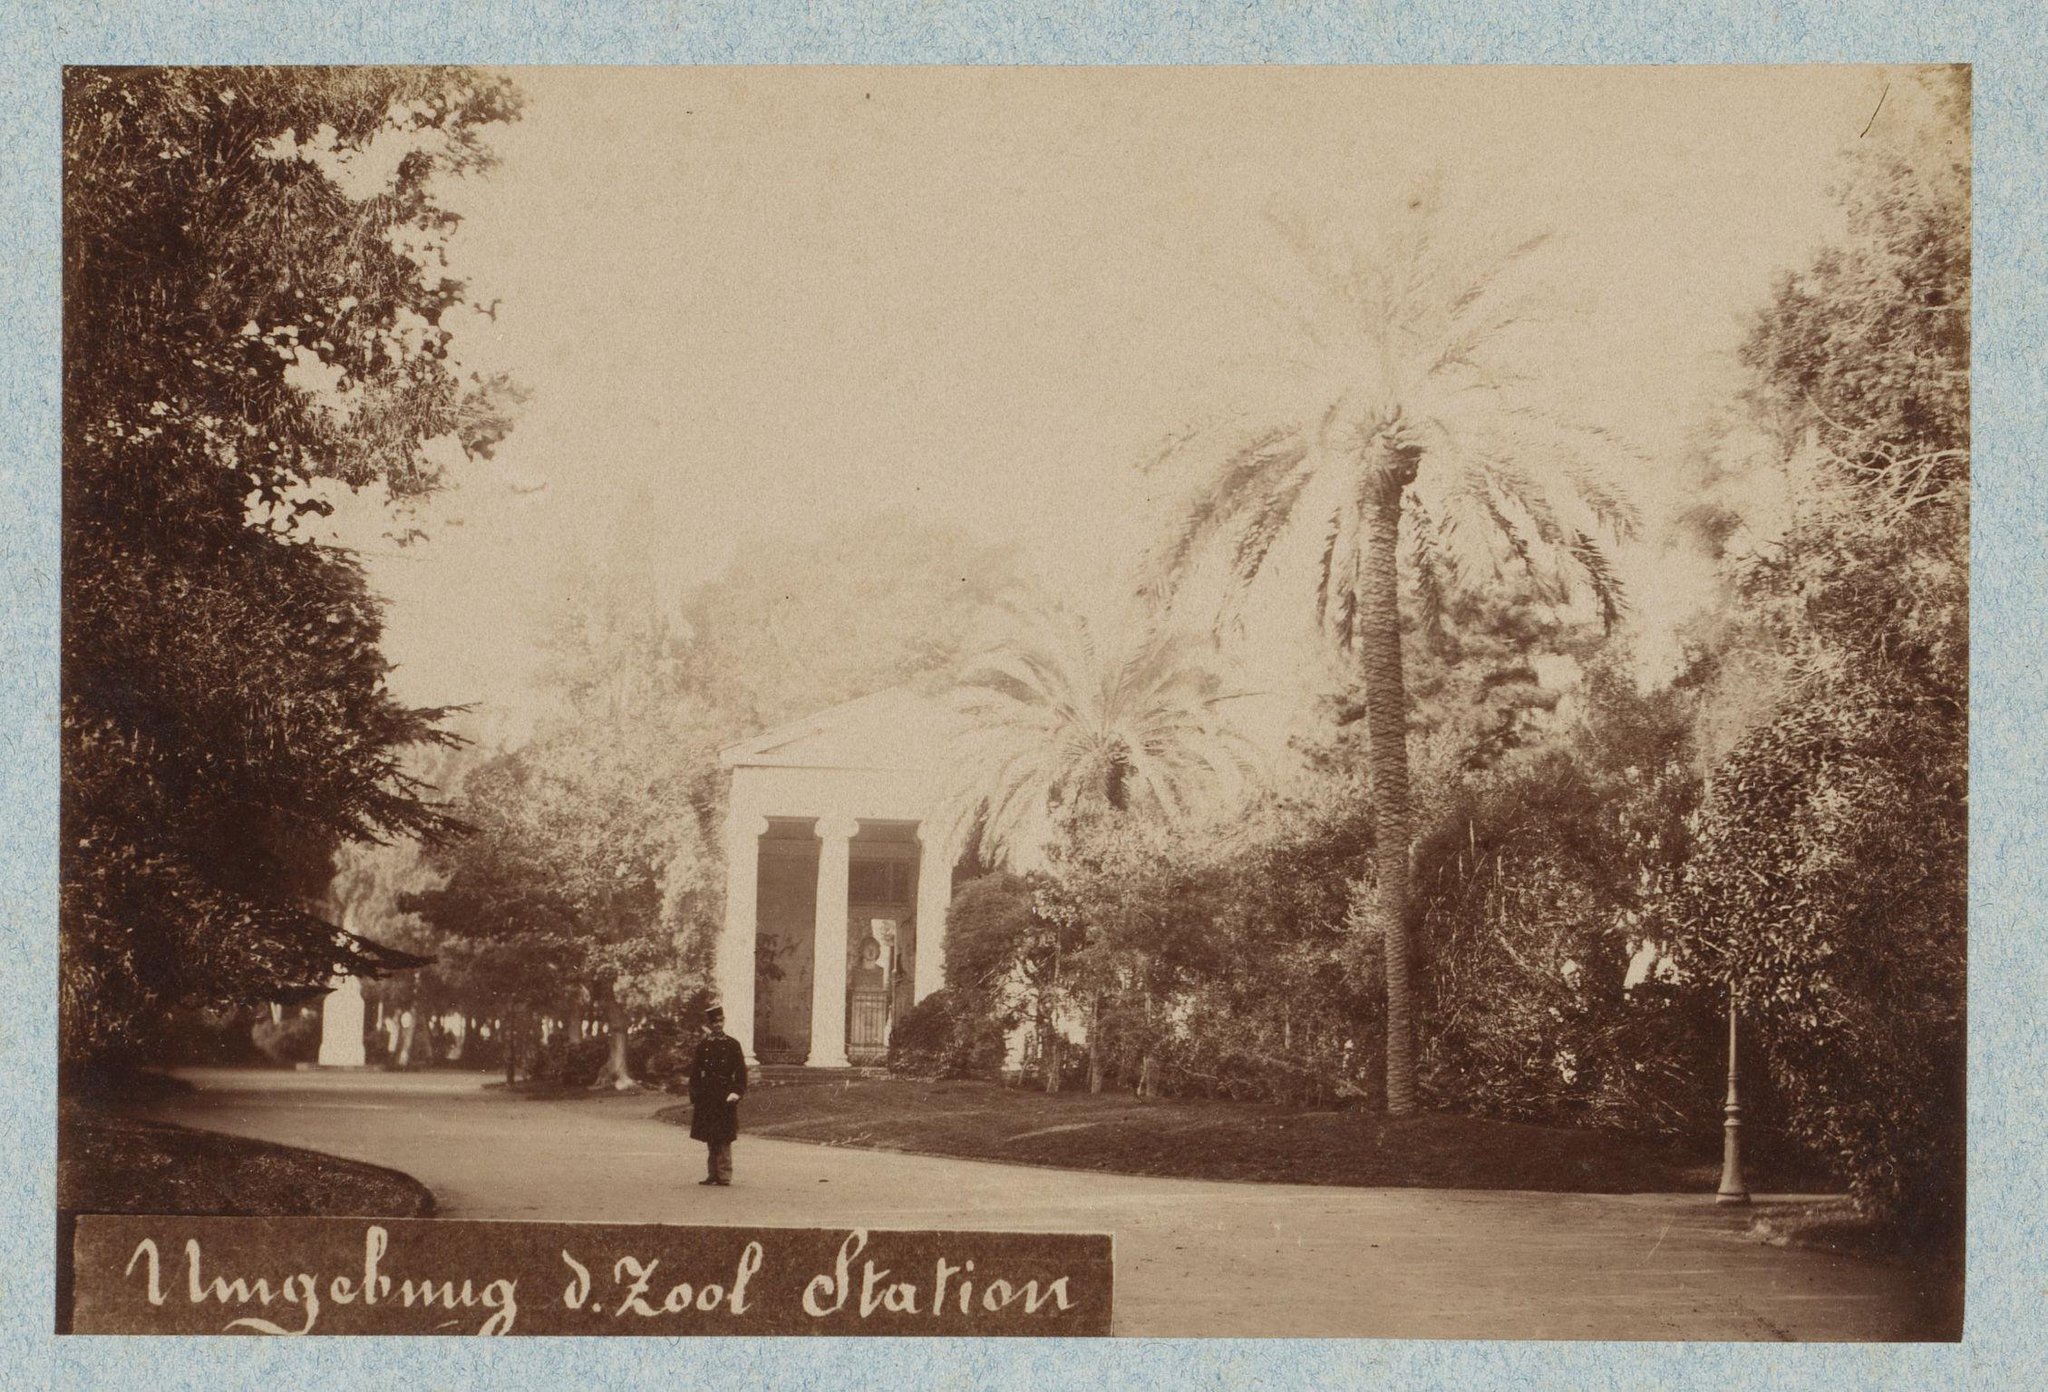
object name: photograph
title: Umgebung d.Zool Station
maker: Anonymous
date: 1874-1900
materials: cardboard, paper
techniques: albumen print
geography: naples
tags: public gardens, park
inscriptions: collector's mark: ‘VOSMAER’